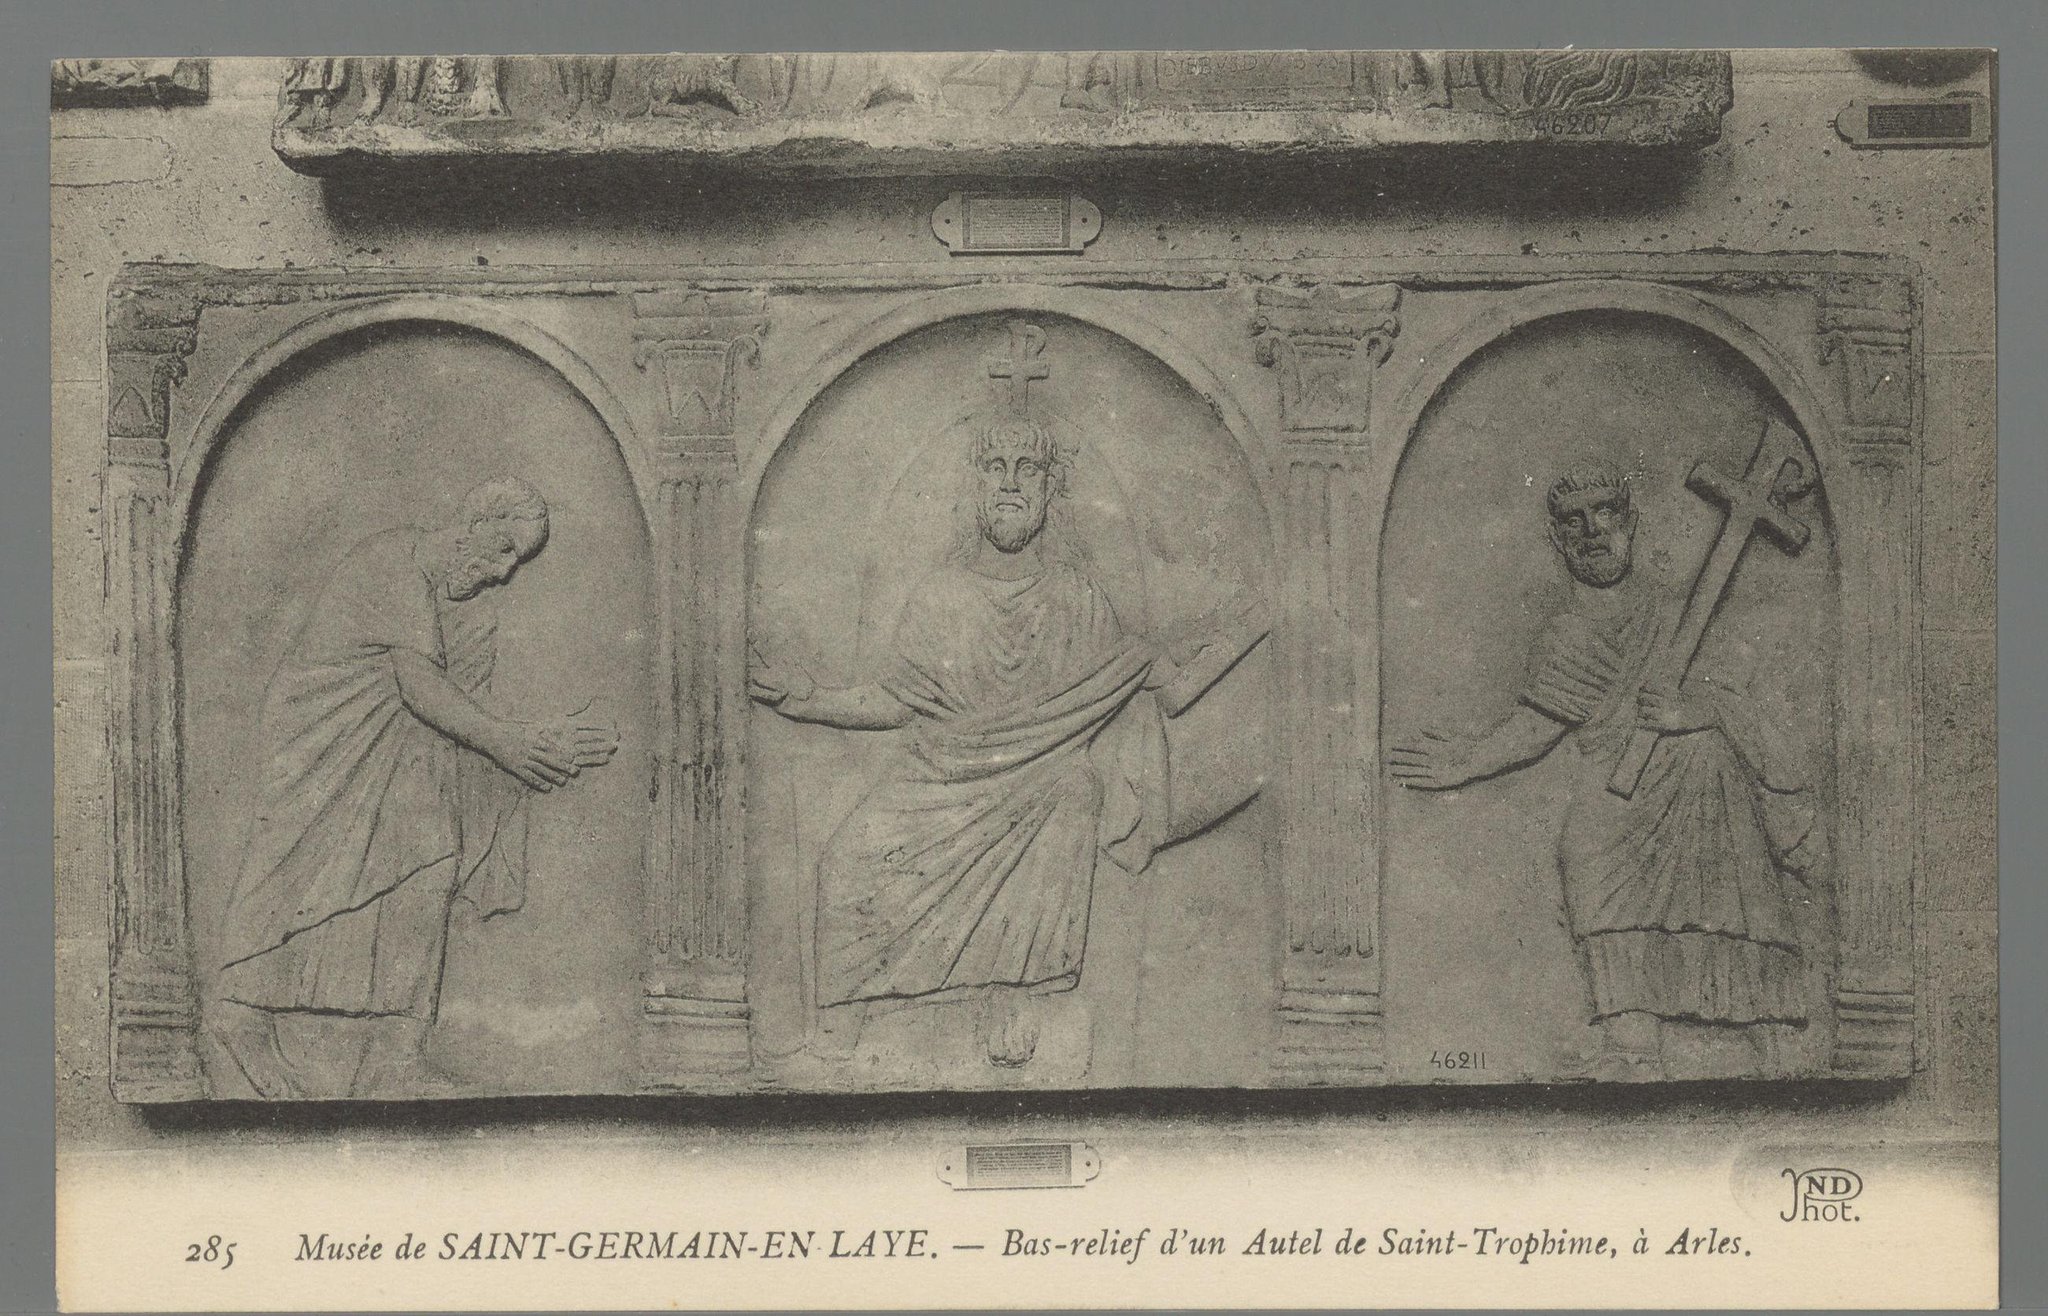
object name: ansichtkaart, prentbriefkaart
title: Musée de Saint-Germain-en-Laye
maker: Anonymous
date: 1903-1918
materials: cardboard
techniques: photograph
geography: saint-germain-en-laye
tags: permanent exhibition, museum, sculpture, altar